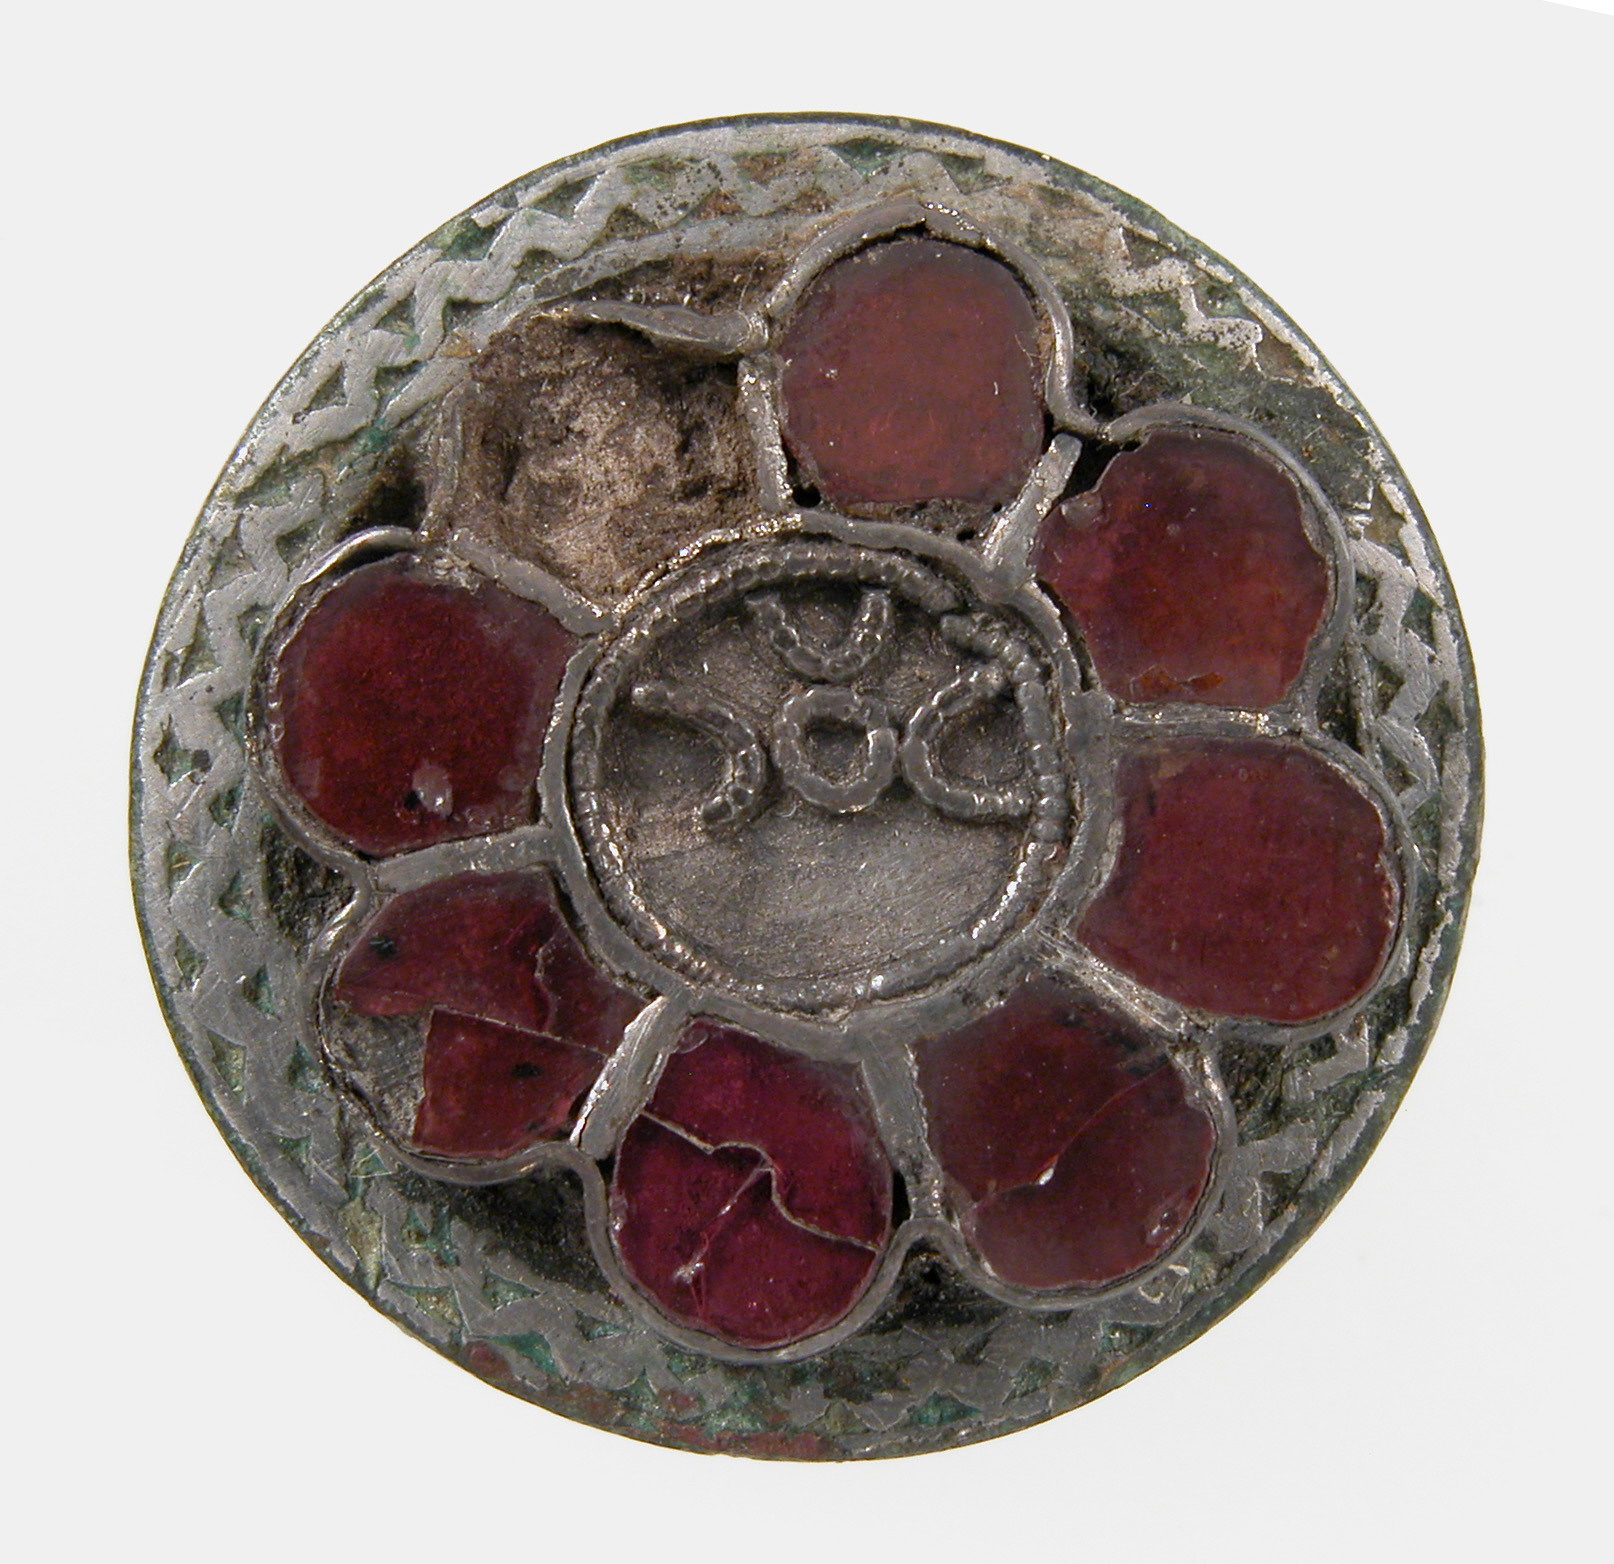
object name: brooch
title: Disk Brooch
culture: frankish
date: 550-650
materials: gemstone, silver